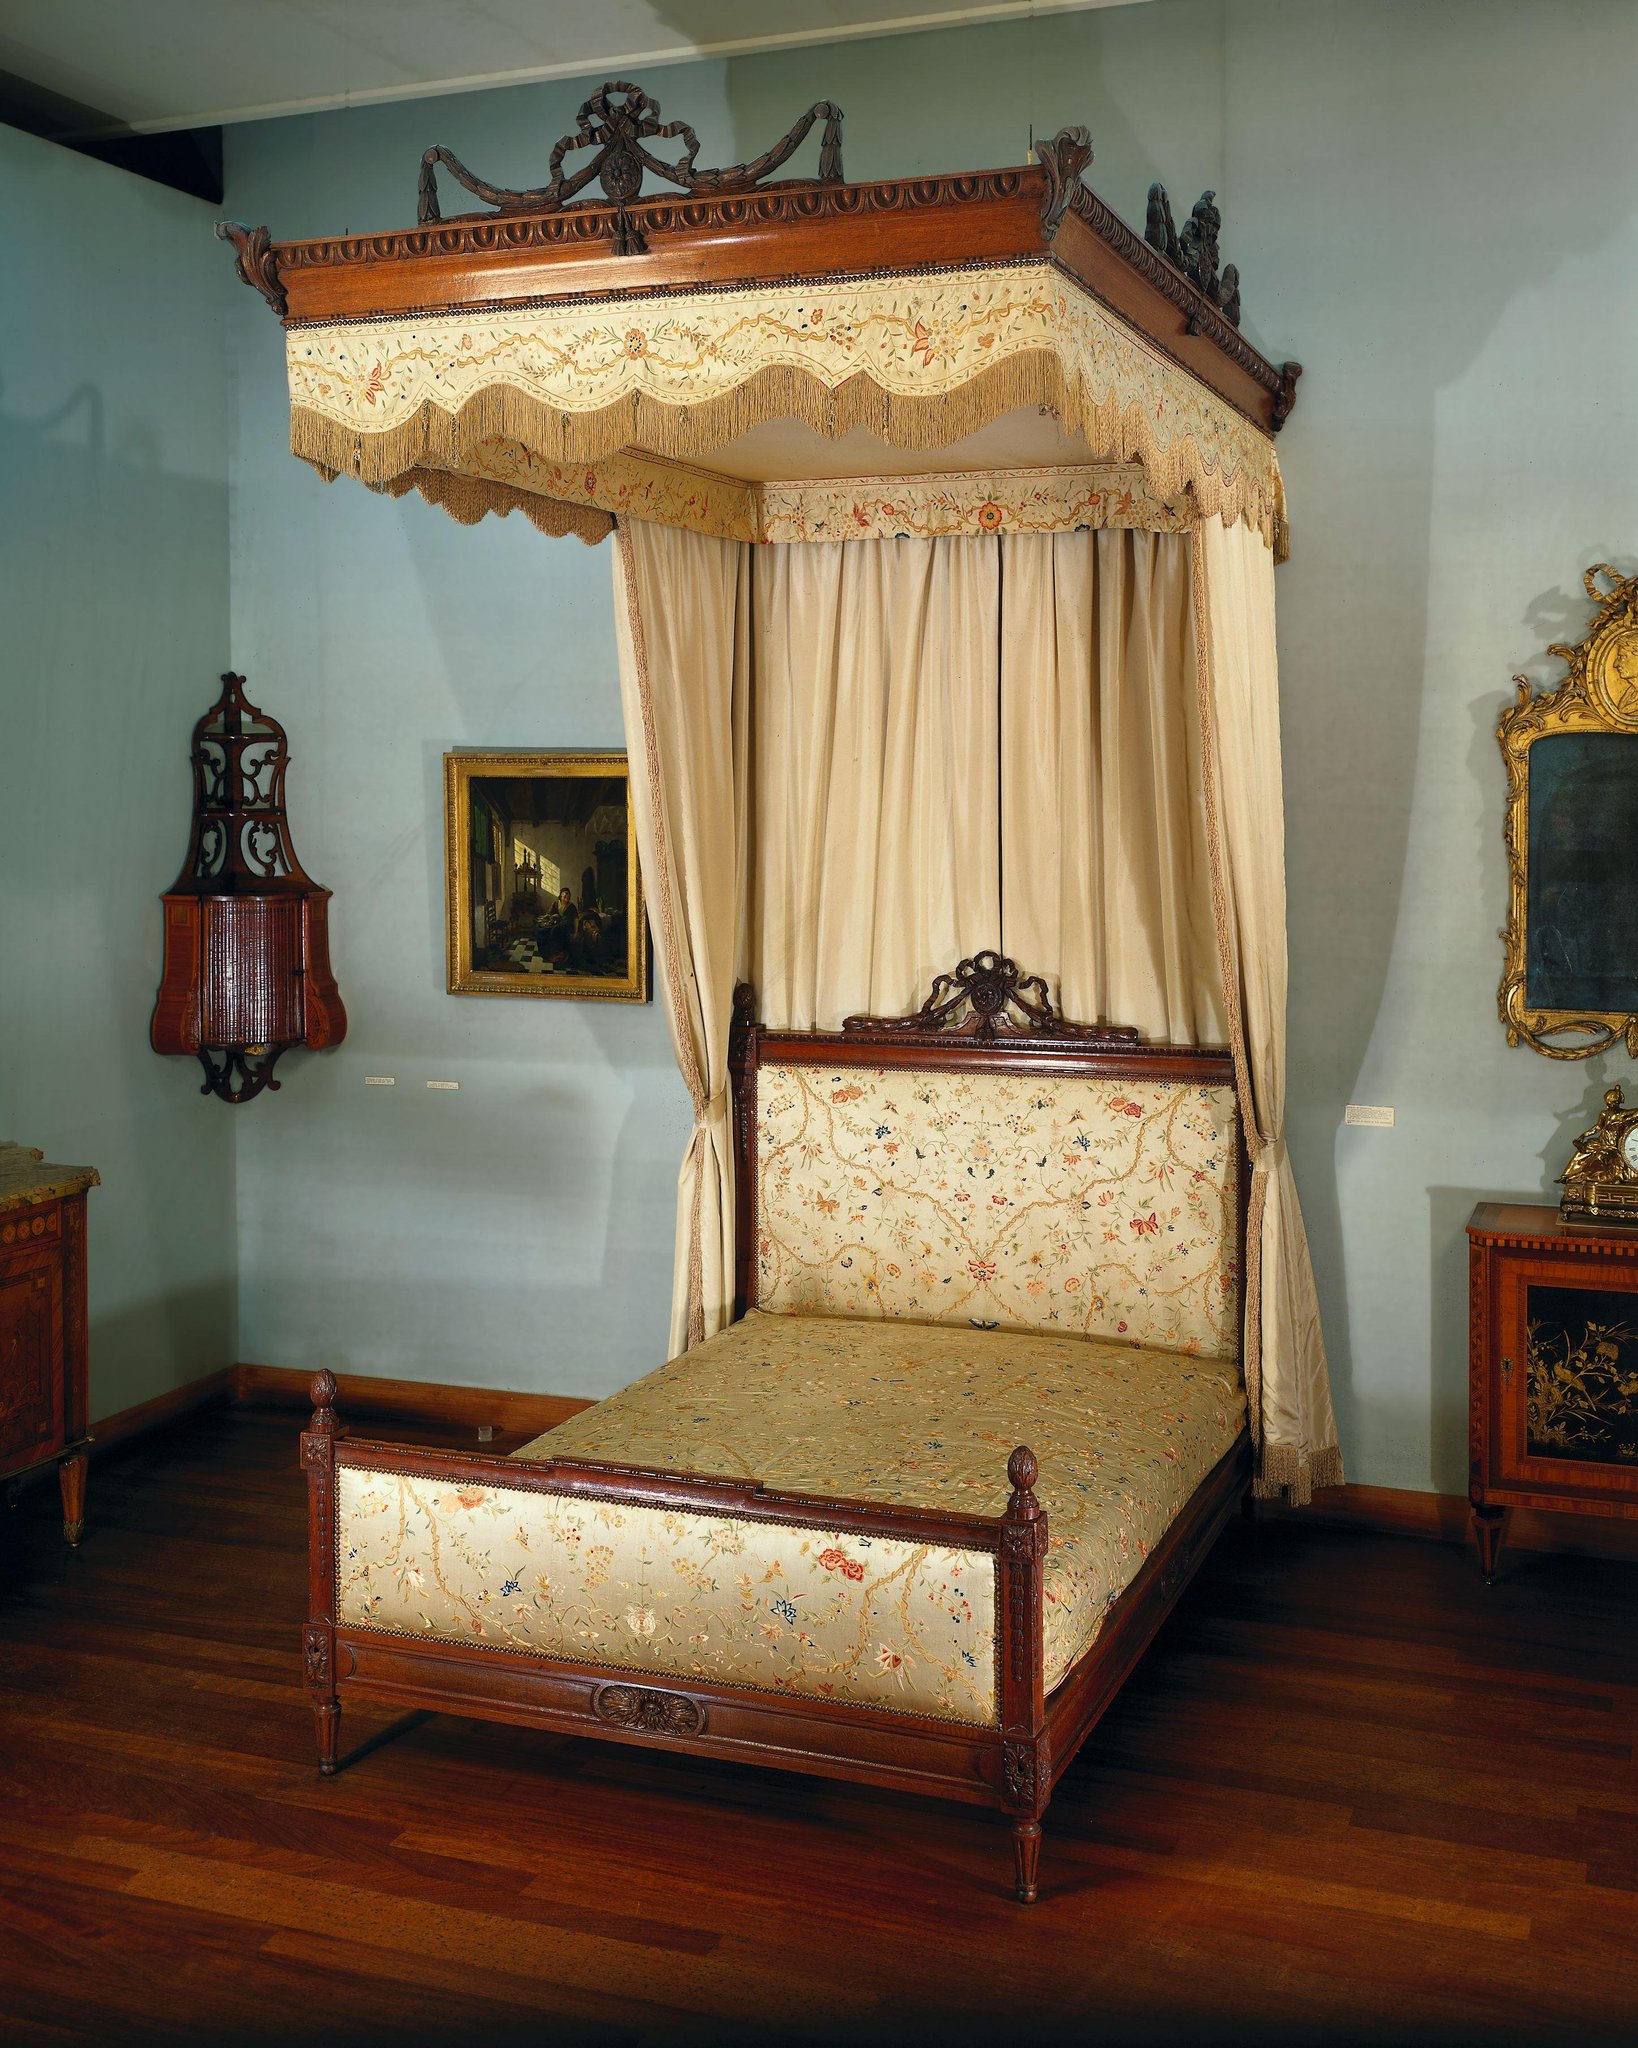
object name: strip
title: Strook, accoladevormig geschulpt, van crème-witte satijn, kleurig geborduurd met een rozet en slingerende rank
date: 1750-1800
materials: silk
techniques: embroidered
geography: china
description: Strook, accoladevormig geschulpt, van crème-witte satijn, kleurig geborduurd met een rozet en slingerende rank. Vormt een pendant met een tweede exemplaar. Chinese zijde.